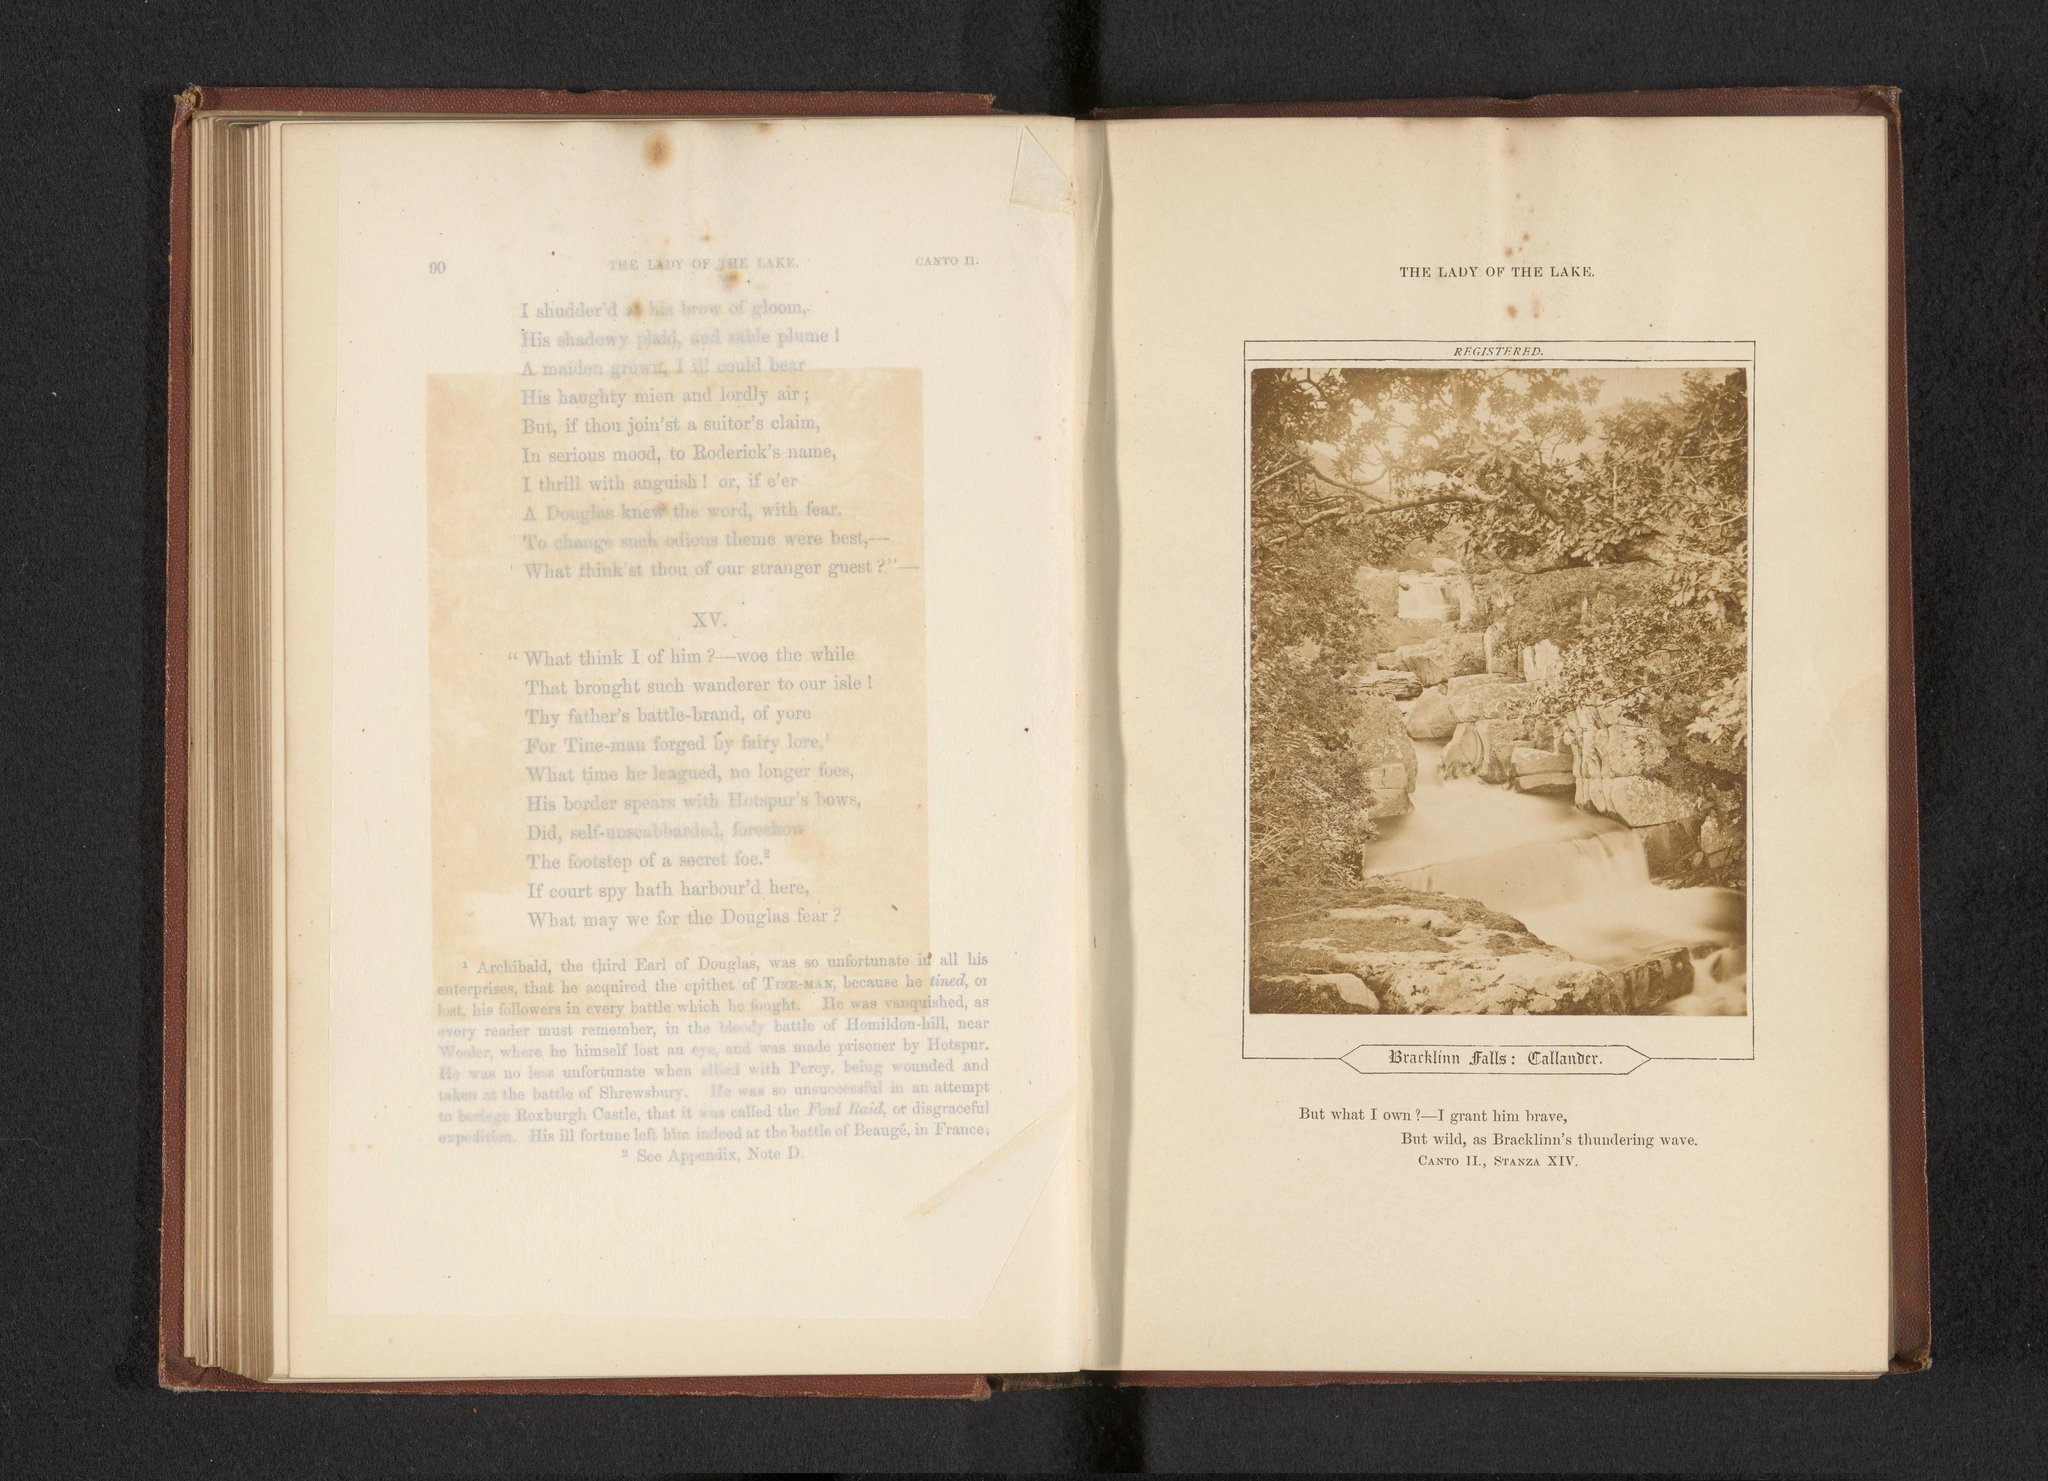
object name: page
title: Bracklinn Falls : Callander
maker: Anonymous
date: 1861-1871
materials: photographic support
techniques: albumen print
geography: scotland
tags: waterfall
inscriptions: inscription: ‘But what I own? - I grant him brave, But wild, as Bracklinn's thundering wave. Canto II., Stanza XIV.’